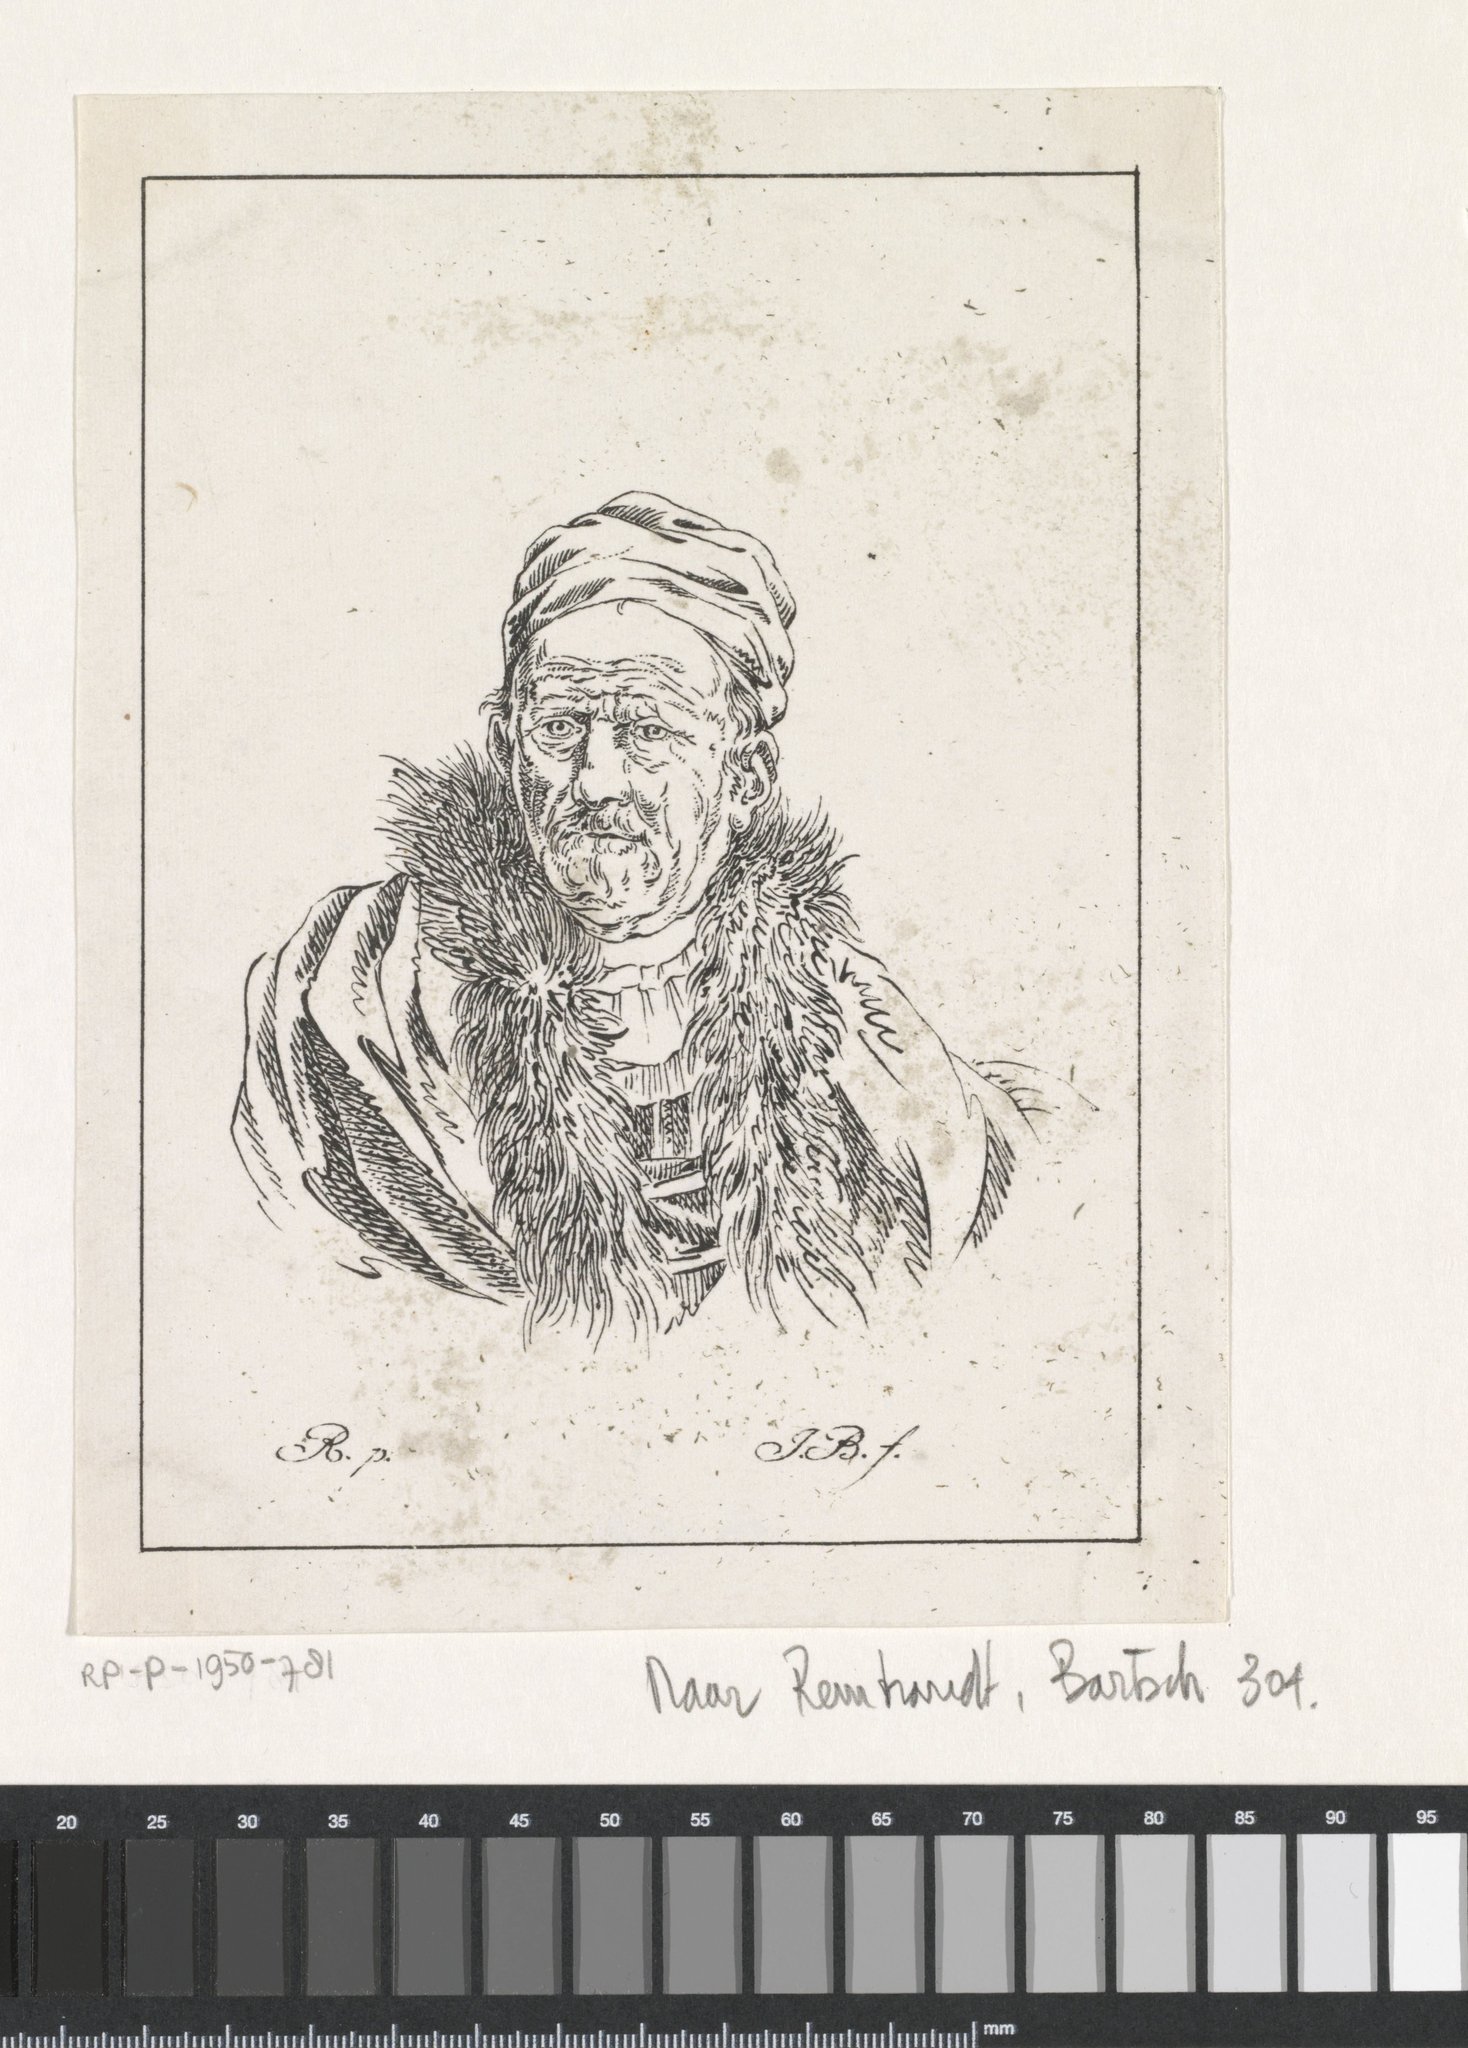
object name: print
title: Mansportret naar Rembrandt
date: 1809-1841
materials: paper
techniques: lithograph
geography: netherlands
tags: anonymous historical person portrayed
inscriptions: collector's mark: Lugt 2228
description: De man draagt een muts en een bontkraag.